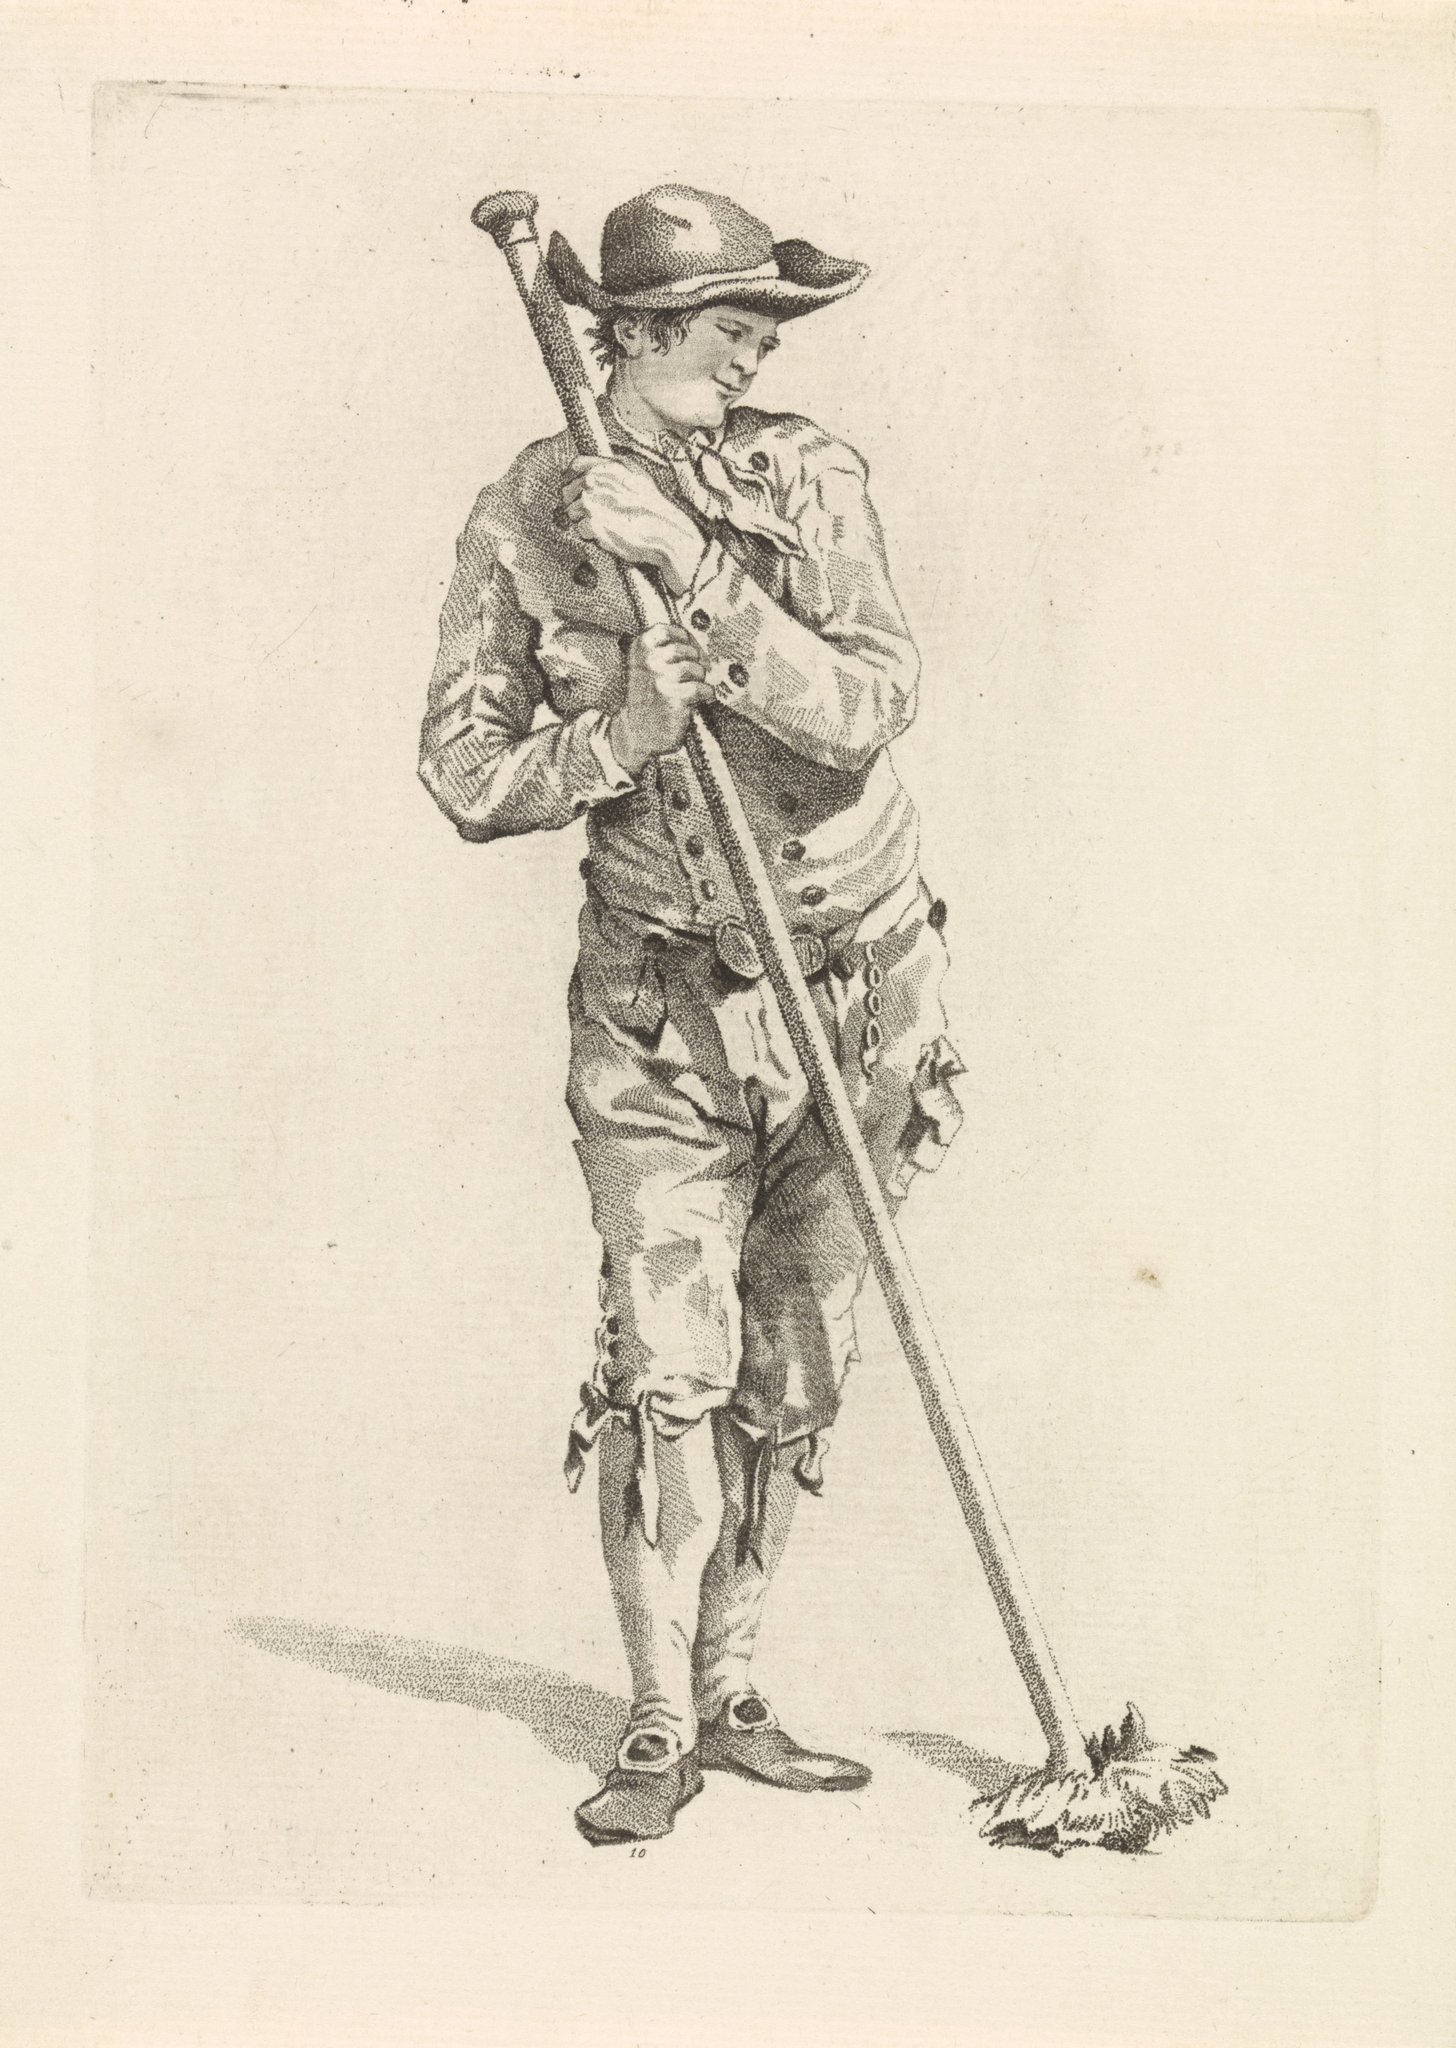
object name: print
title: Schoorsteenveger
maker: mathias de sallieth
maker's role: print maker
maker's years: 1749-1791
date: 1772-1791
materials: paper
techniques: printmaking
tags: adult man, head-gear: hat (+ men's clothes), handicrafts ~ maintenance and repair (with name of trade or profession)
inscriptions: collector's mark: Lugt 2228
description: De prent verscheen vanaf 1818 tevens als onderdeel van een 33-delige reeks prenten door Mathias de Sallieth, samengebonden in: Perkois, Jacobus, Prins, Johannes Huibert. Verzameling van verschillende gekleede mans- en vrouwenstanden, ter oefening van jonge schilders en liefhebbers. Rotterdam: Johannes Immerzeel, 1818.